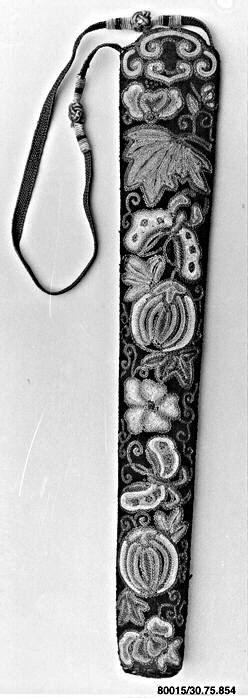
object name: fan holder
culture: chinese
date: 1701-1900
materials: metal thread, silk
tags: butterflies,flowers